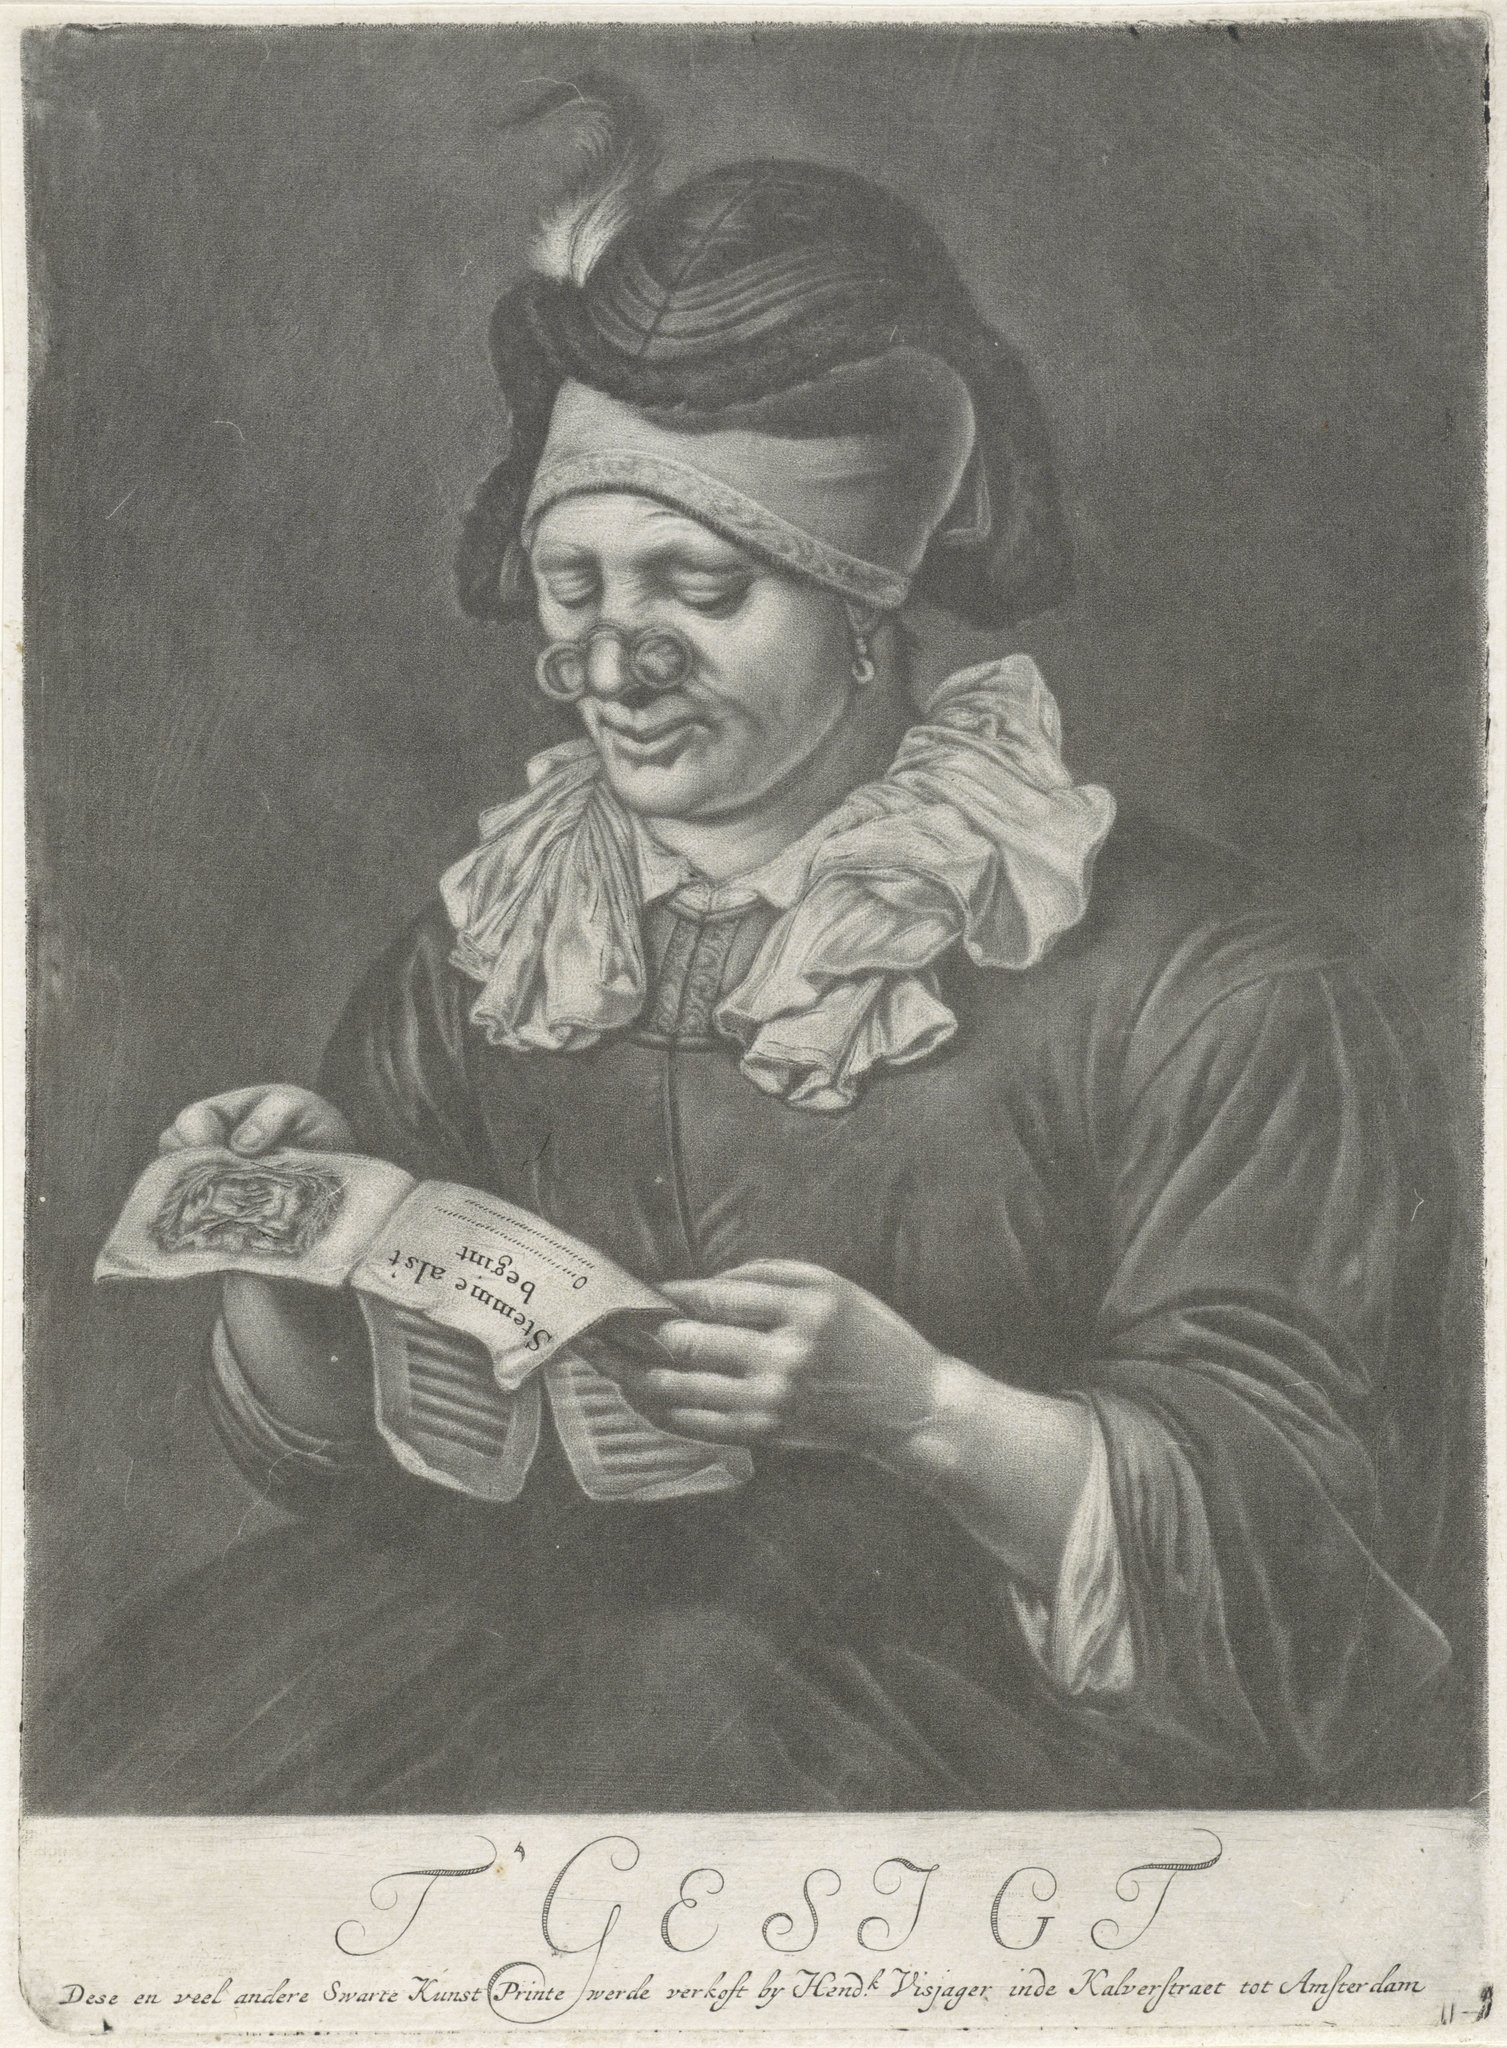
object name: print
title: De vijf zintuigen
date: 1683-1684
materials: paper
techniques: mezzotint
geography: amsterdam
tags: eyeglasses, spectacles, reading, sight, looking (one of the five senses)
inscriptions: collector's mark: Lugt 2228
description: Een vrouw met een knijpbril op haar neus zit te lezen. De prent maakt deel uit van een serie van vijf prenten met de vijf zintuigen.